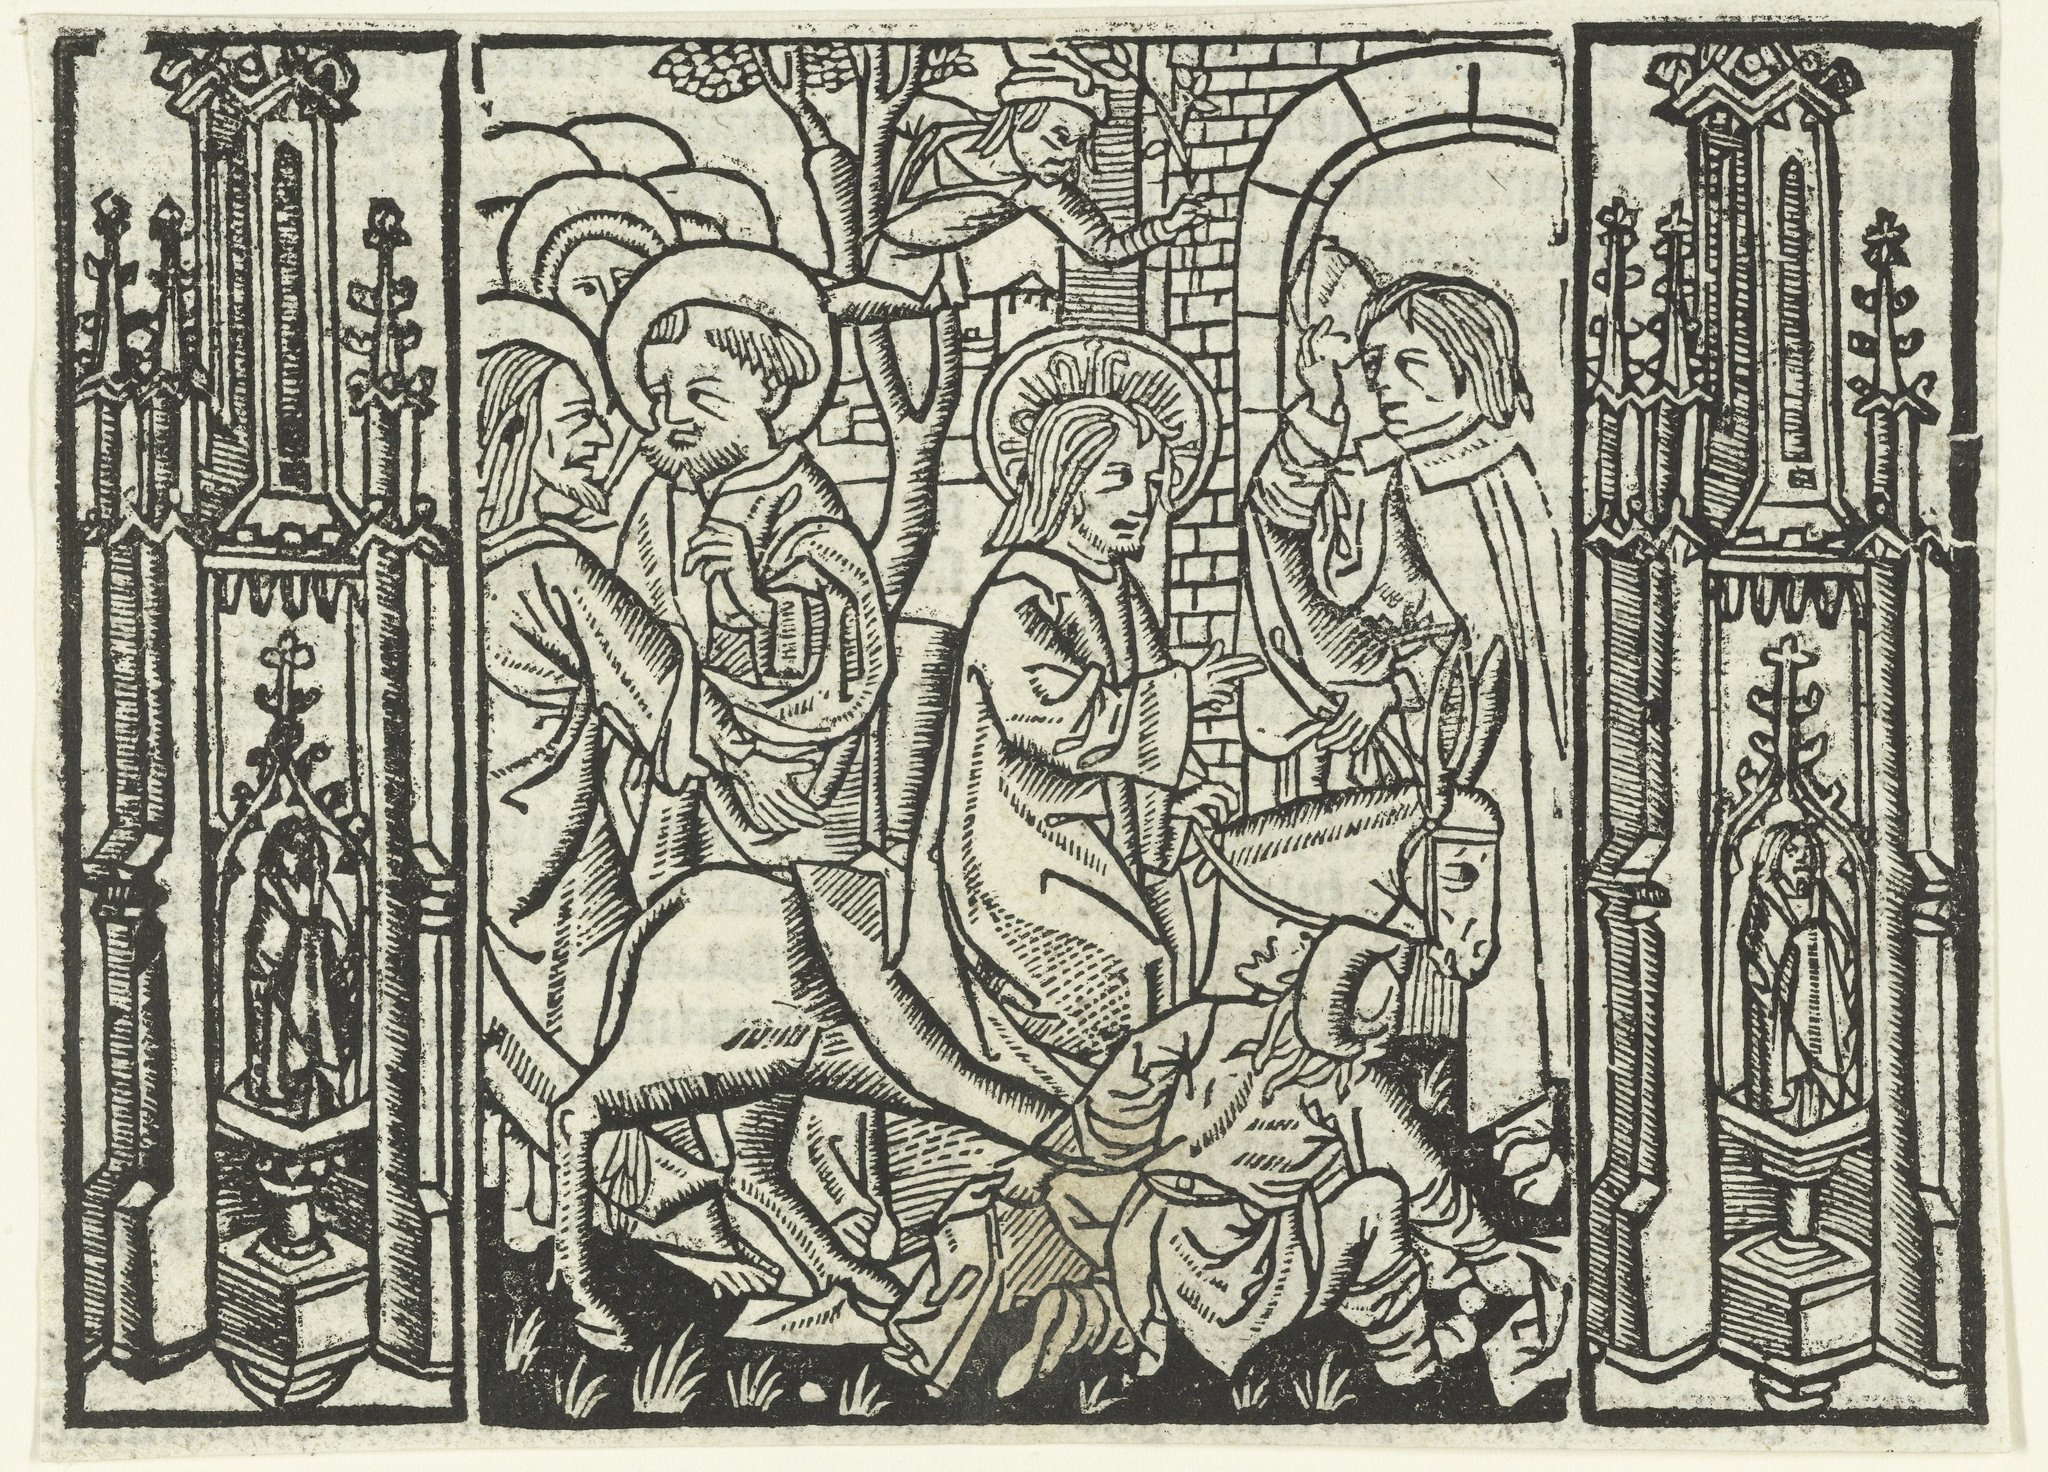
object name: print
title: De intocht in Jerusalem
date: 1480-1500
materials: paper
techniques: woodcut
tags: entry into jerusalem: people spreading their clothes before christ on the ass, and waving palm branches (matthew 21:1-11, 21:14-16; mark 11:1-11; luke 19:28-40; john 12:12-19)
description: Eén blad van 113 uit Ludolphus de Saxonia, "Dit es dleué ons liefs heeren ihesu christi". Anonieme Nederlandse vertaling. Uitgegeven door Henrick Eckert van Homberch te Antwerpen in 1503. Botke, K. Deze 113 houtsneden, die meestal reeds in vroege Nederlandse boeken gebruikt zijn, worden toegeschreven aan de tweede Meester van Delft, de Meester van de Delbecq-Schreiber-passie en de Meester van de Virgo inter Virgines. In Conway (1884) en in "De gulden passer"(1951) zijn ook eerdere versies opgenomen. Botke, K.